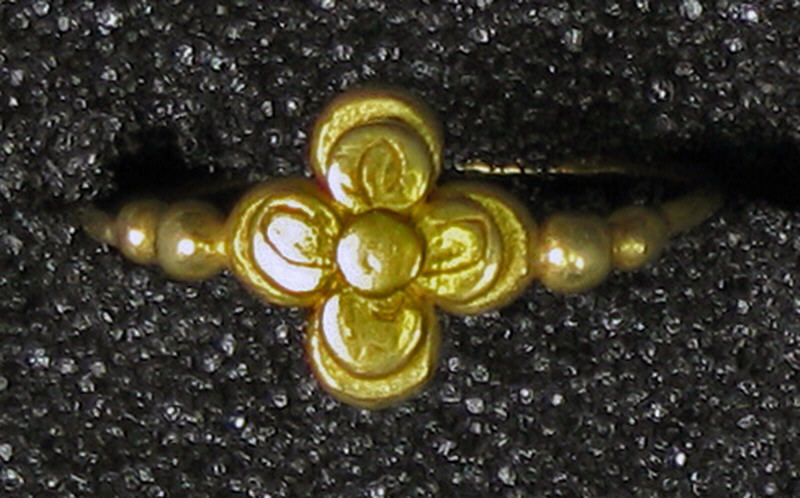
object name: ring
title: Ring with Ogee Centre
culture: indonesian, central java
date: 701-1200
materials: gold